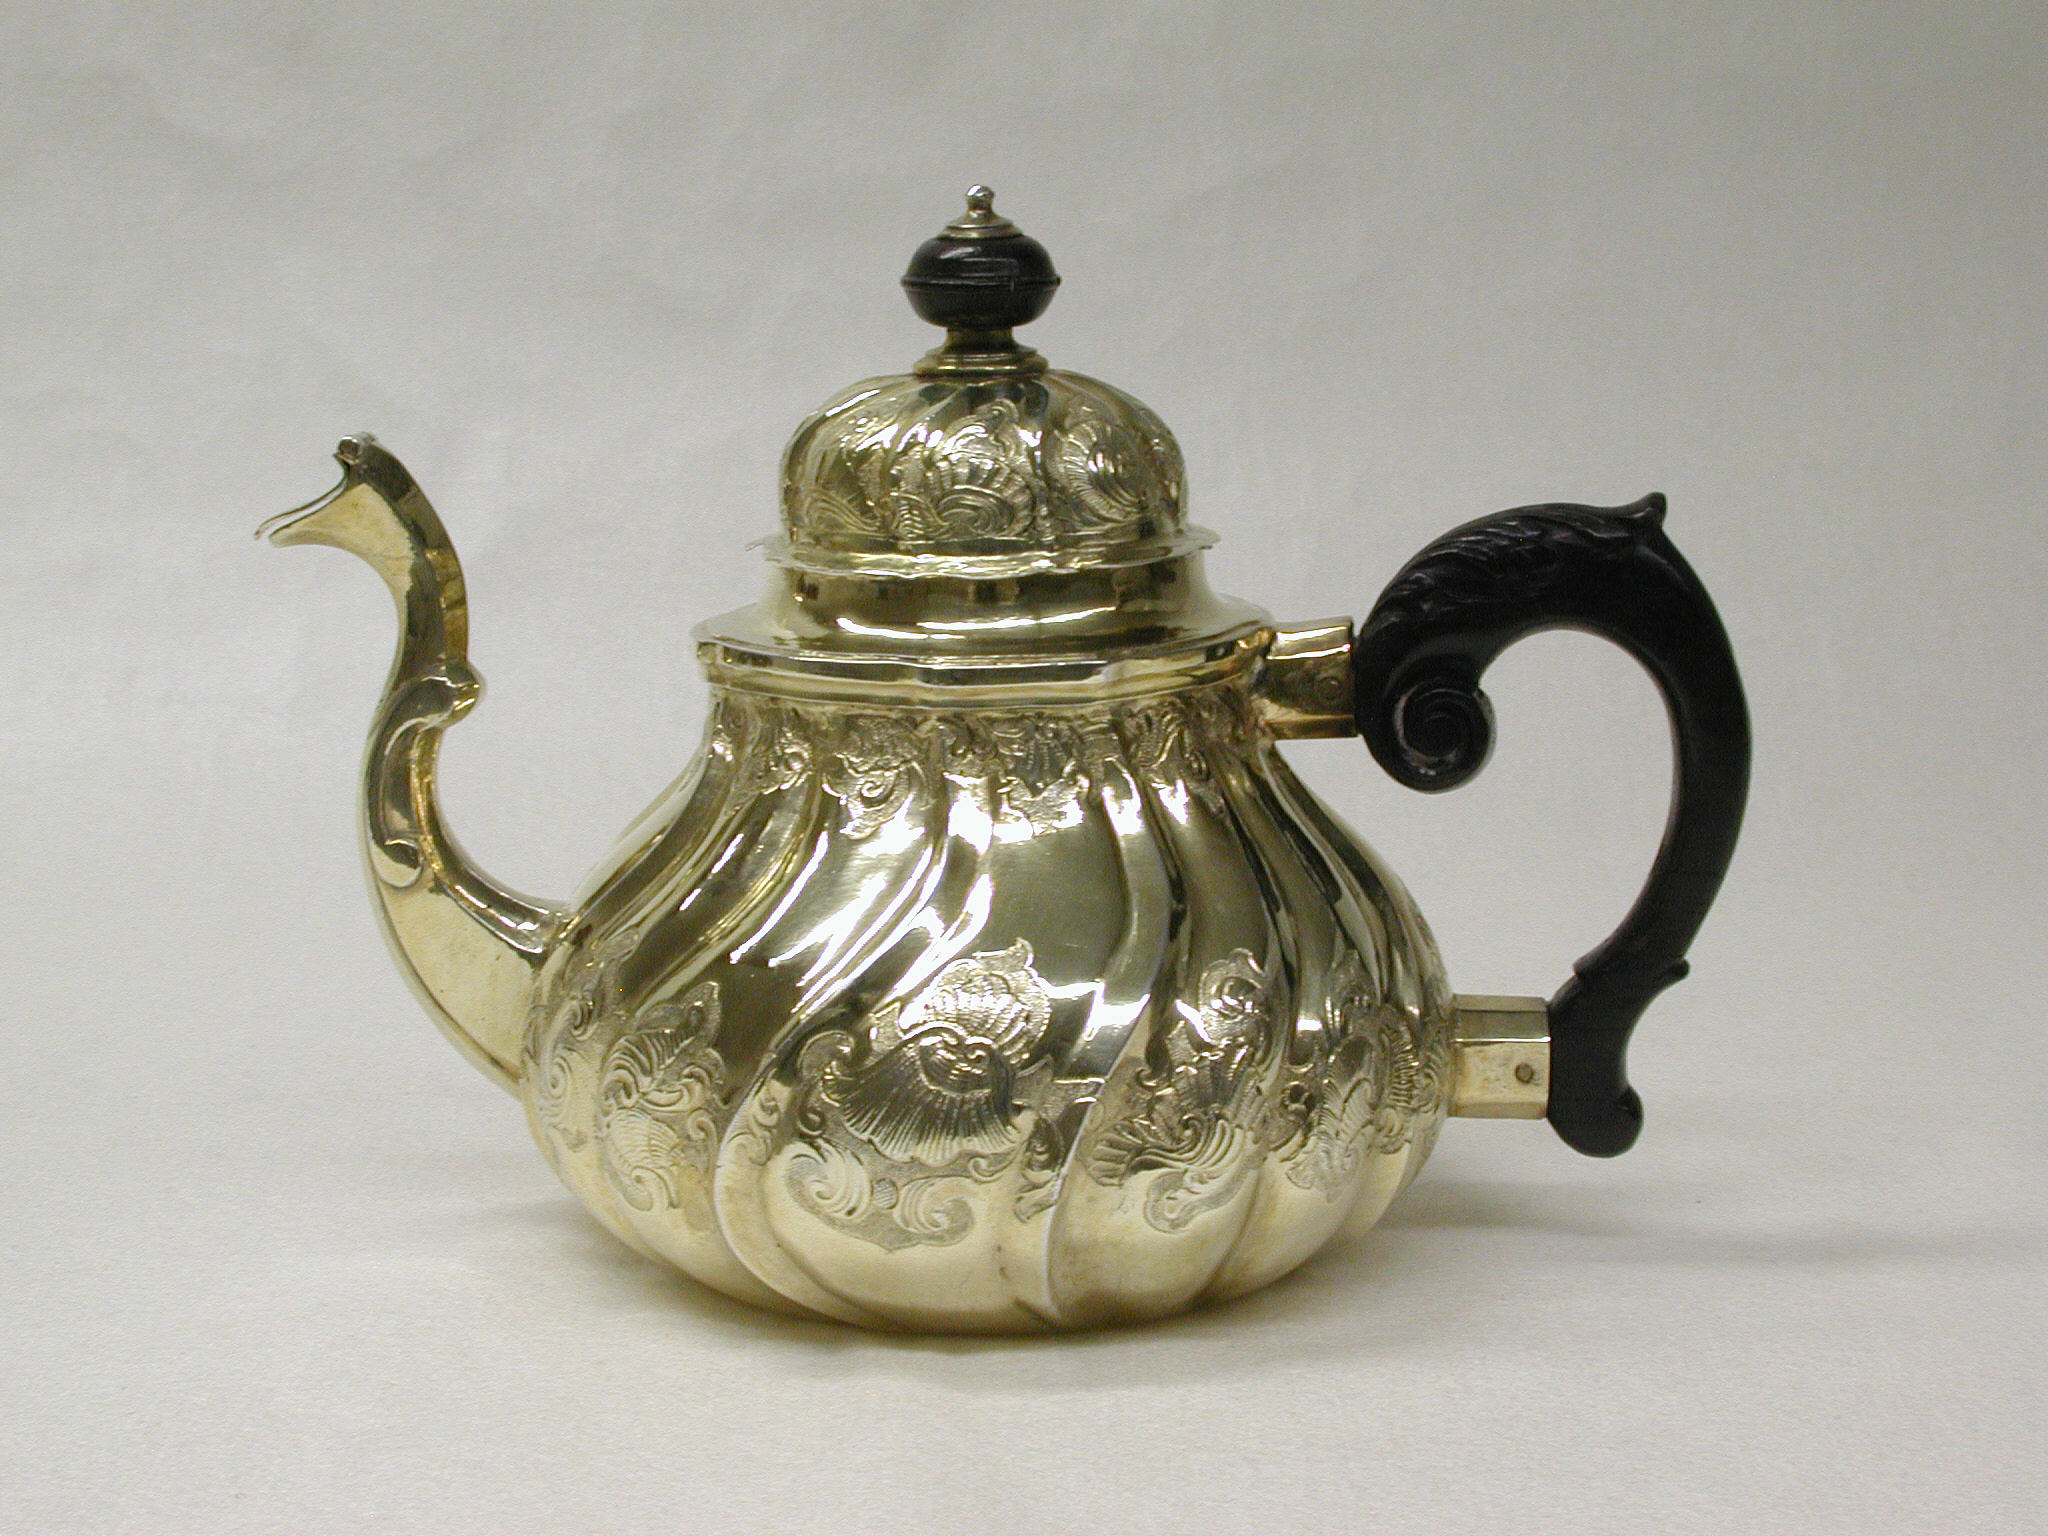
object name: teapot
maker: andreas friedrich stemmler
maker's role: maker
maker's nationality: german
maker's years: 1745-1755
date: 1743-1745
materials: silver gilt, wood